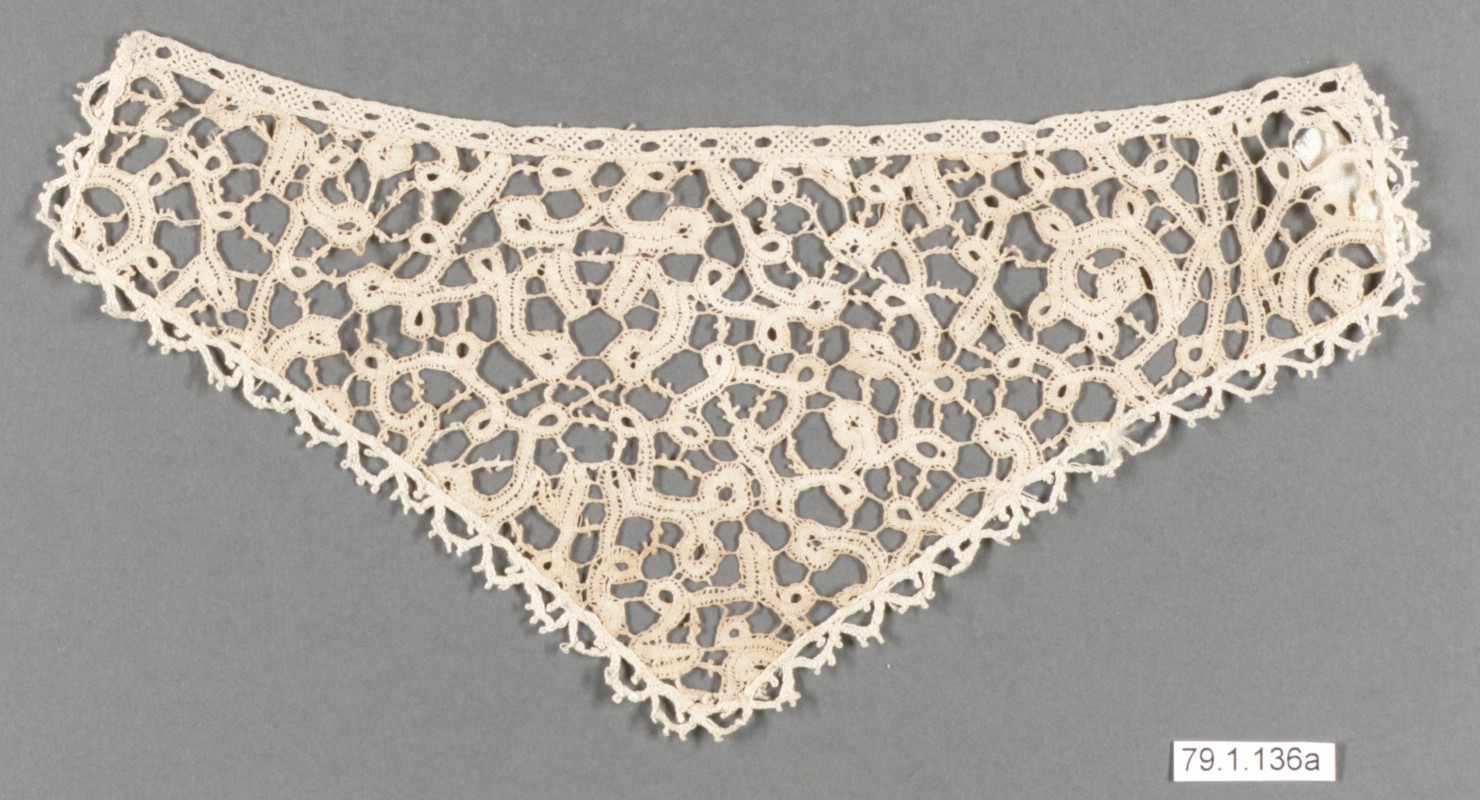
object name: collar and cuff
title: Pair of cuffs and collar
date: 1601-1700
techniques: lace